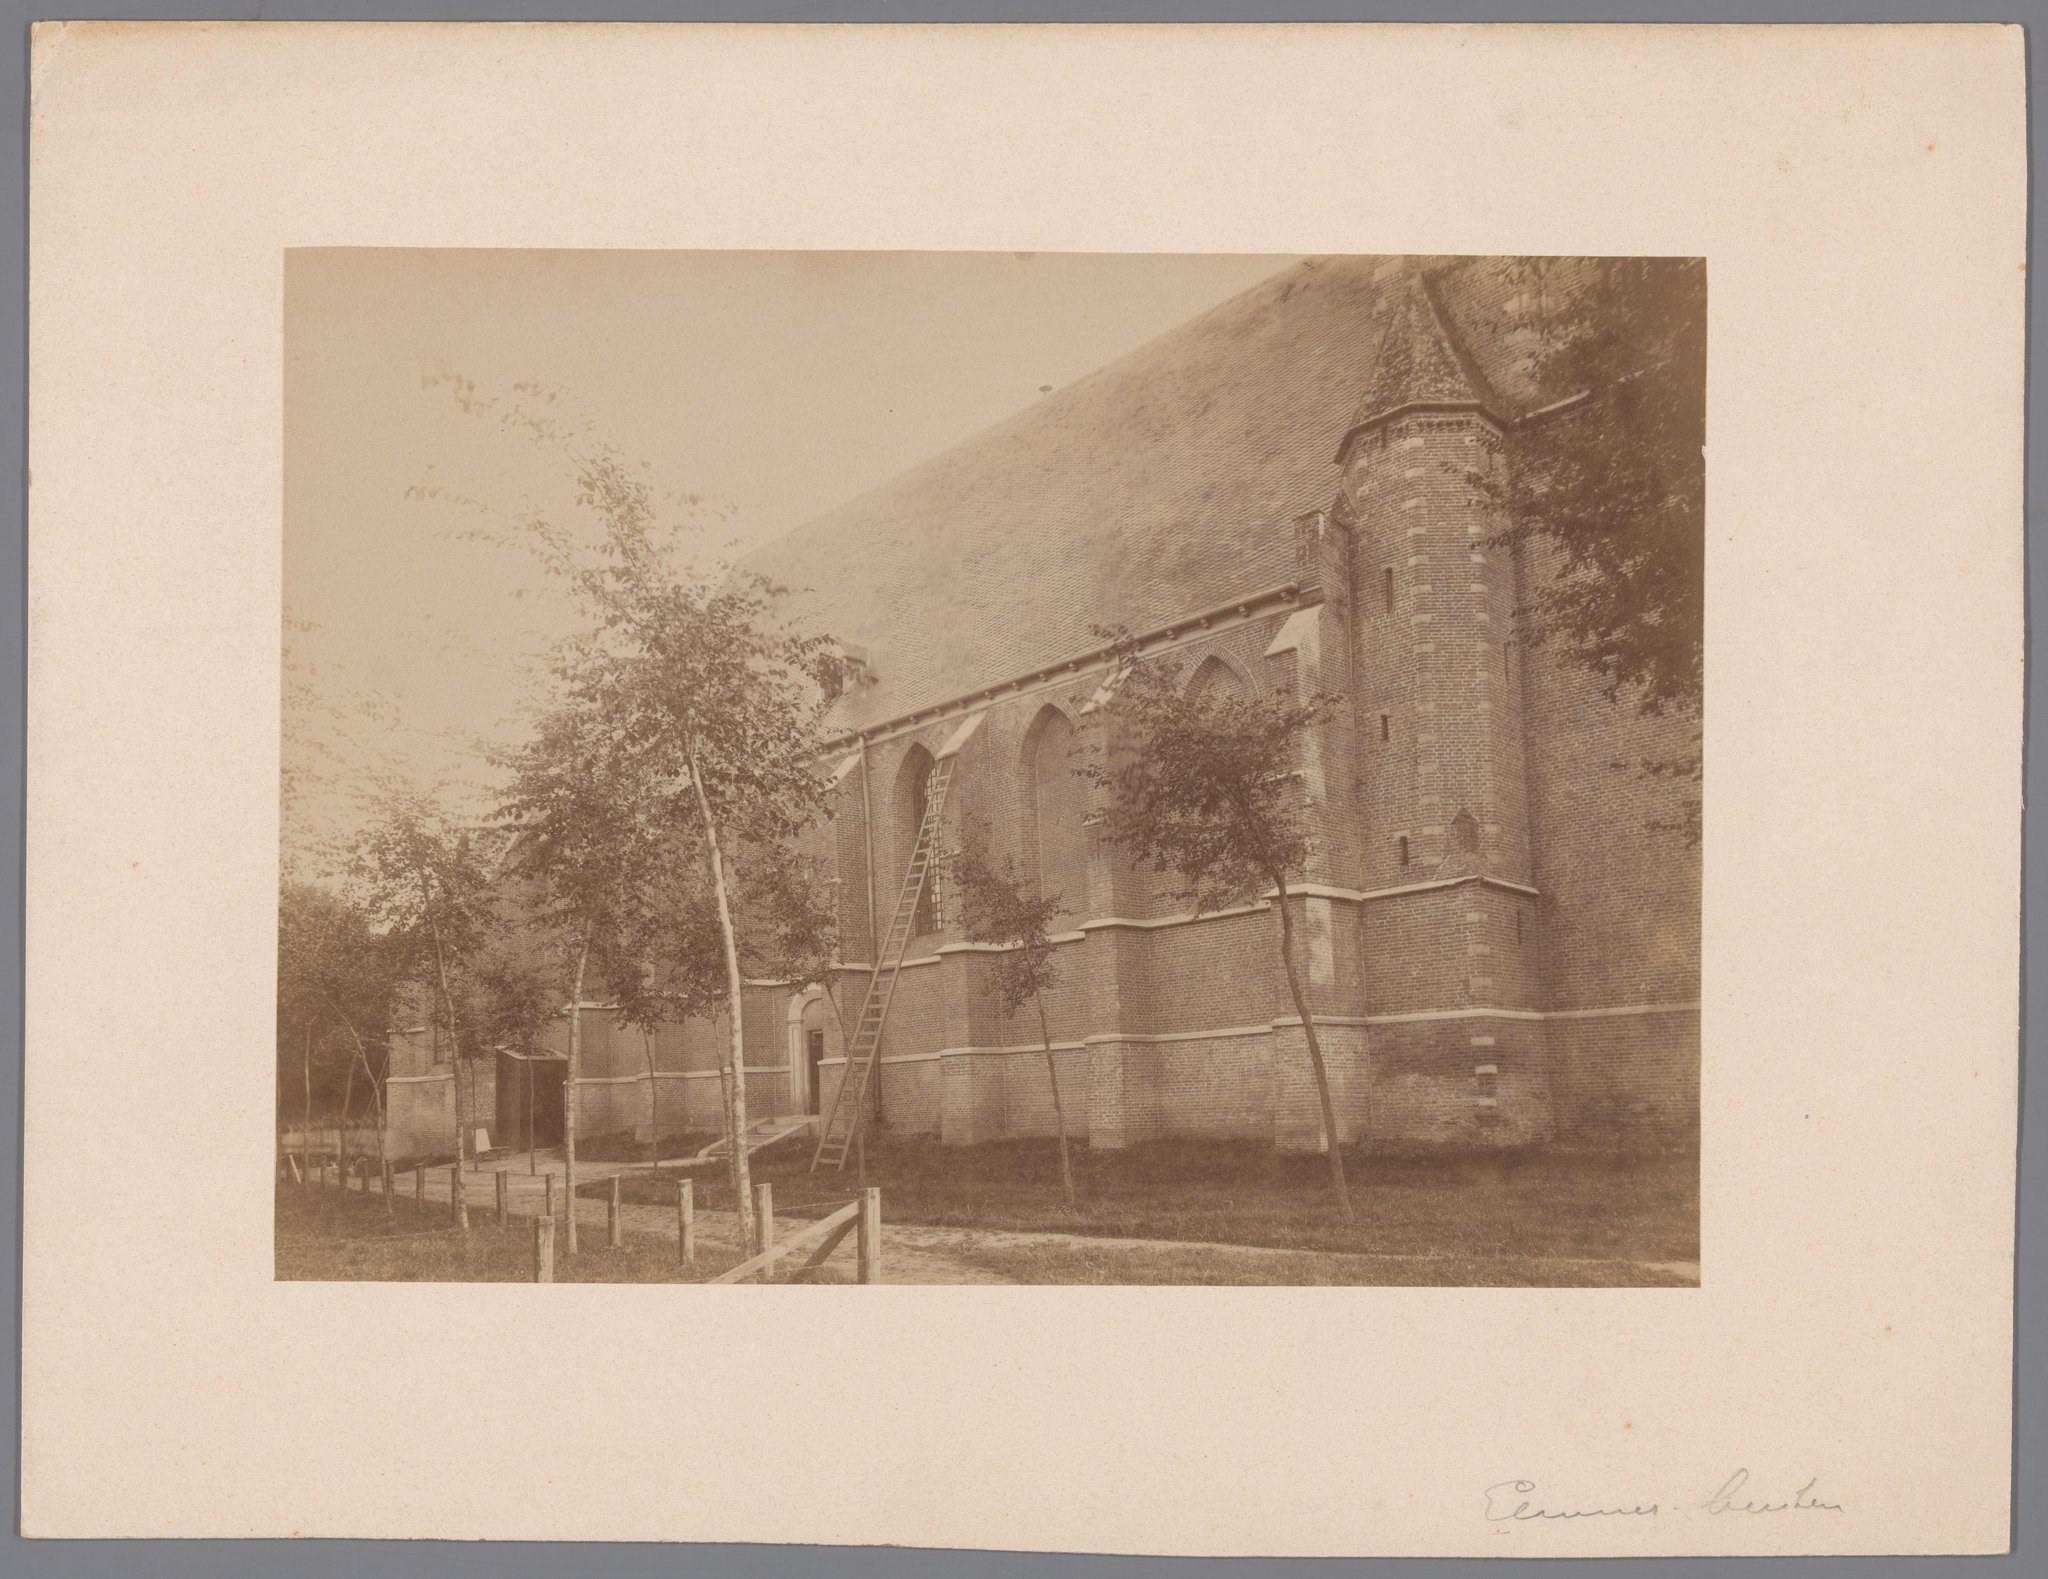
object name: photograph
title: Noordzijde van de Hervormde Kerk te Eemnes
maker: anoniem (monumentenzorg)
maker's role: fotograaf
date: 1900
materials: cardboard, photographic support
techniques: albumen print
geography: eemnes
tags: church (exterior)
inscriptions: annotation: ‘Eemnes-buiten’, annotation: ‘Eemnes-buiten (U.)/ N.H. kerk/ sept 1900’